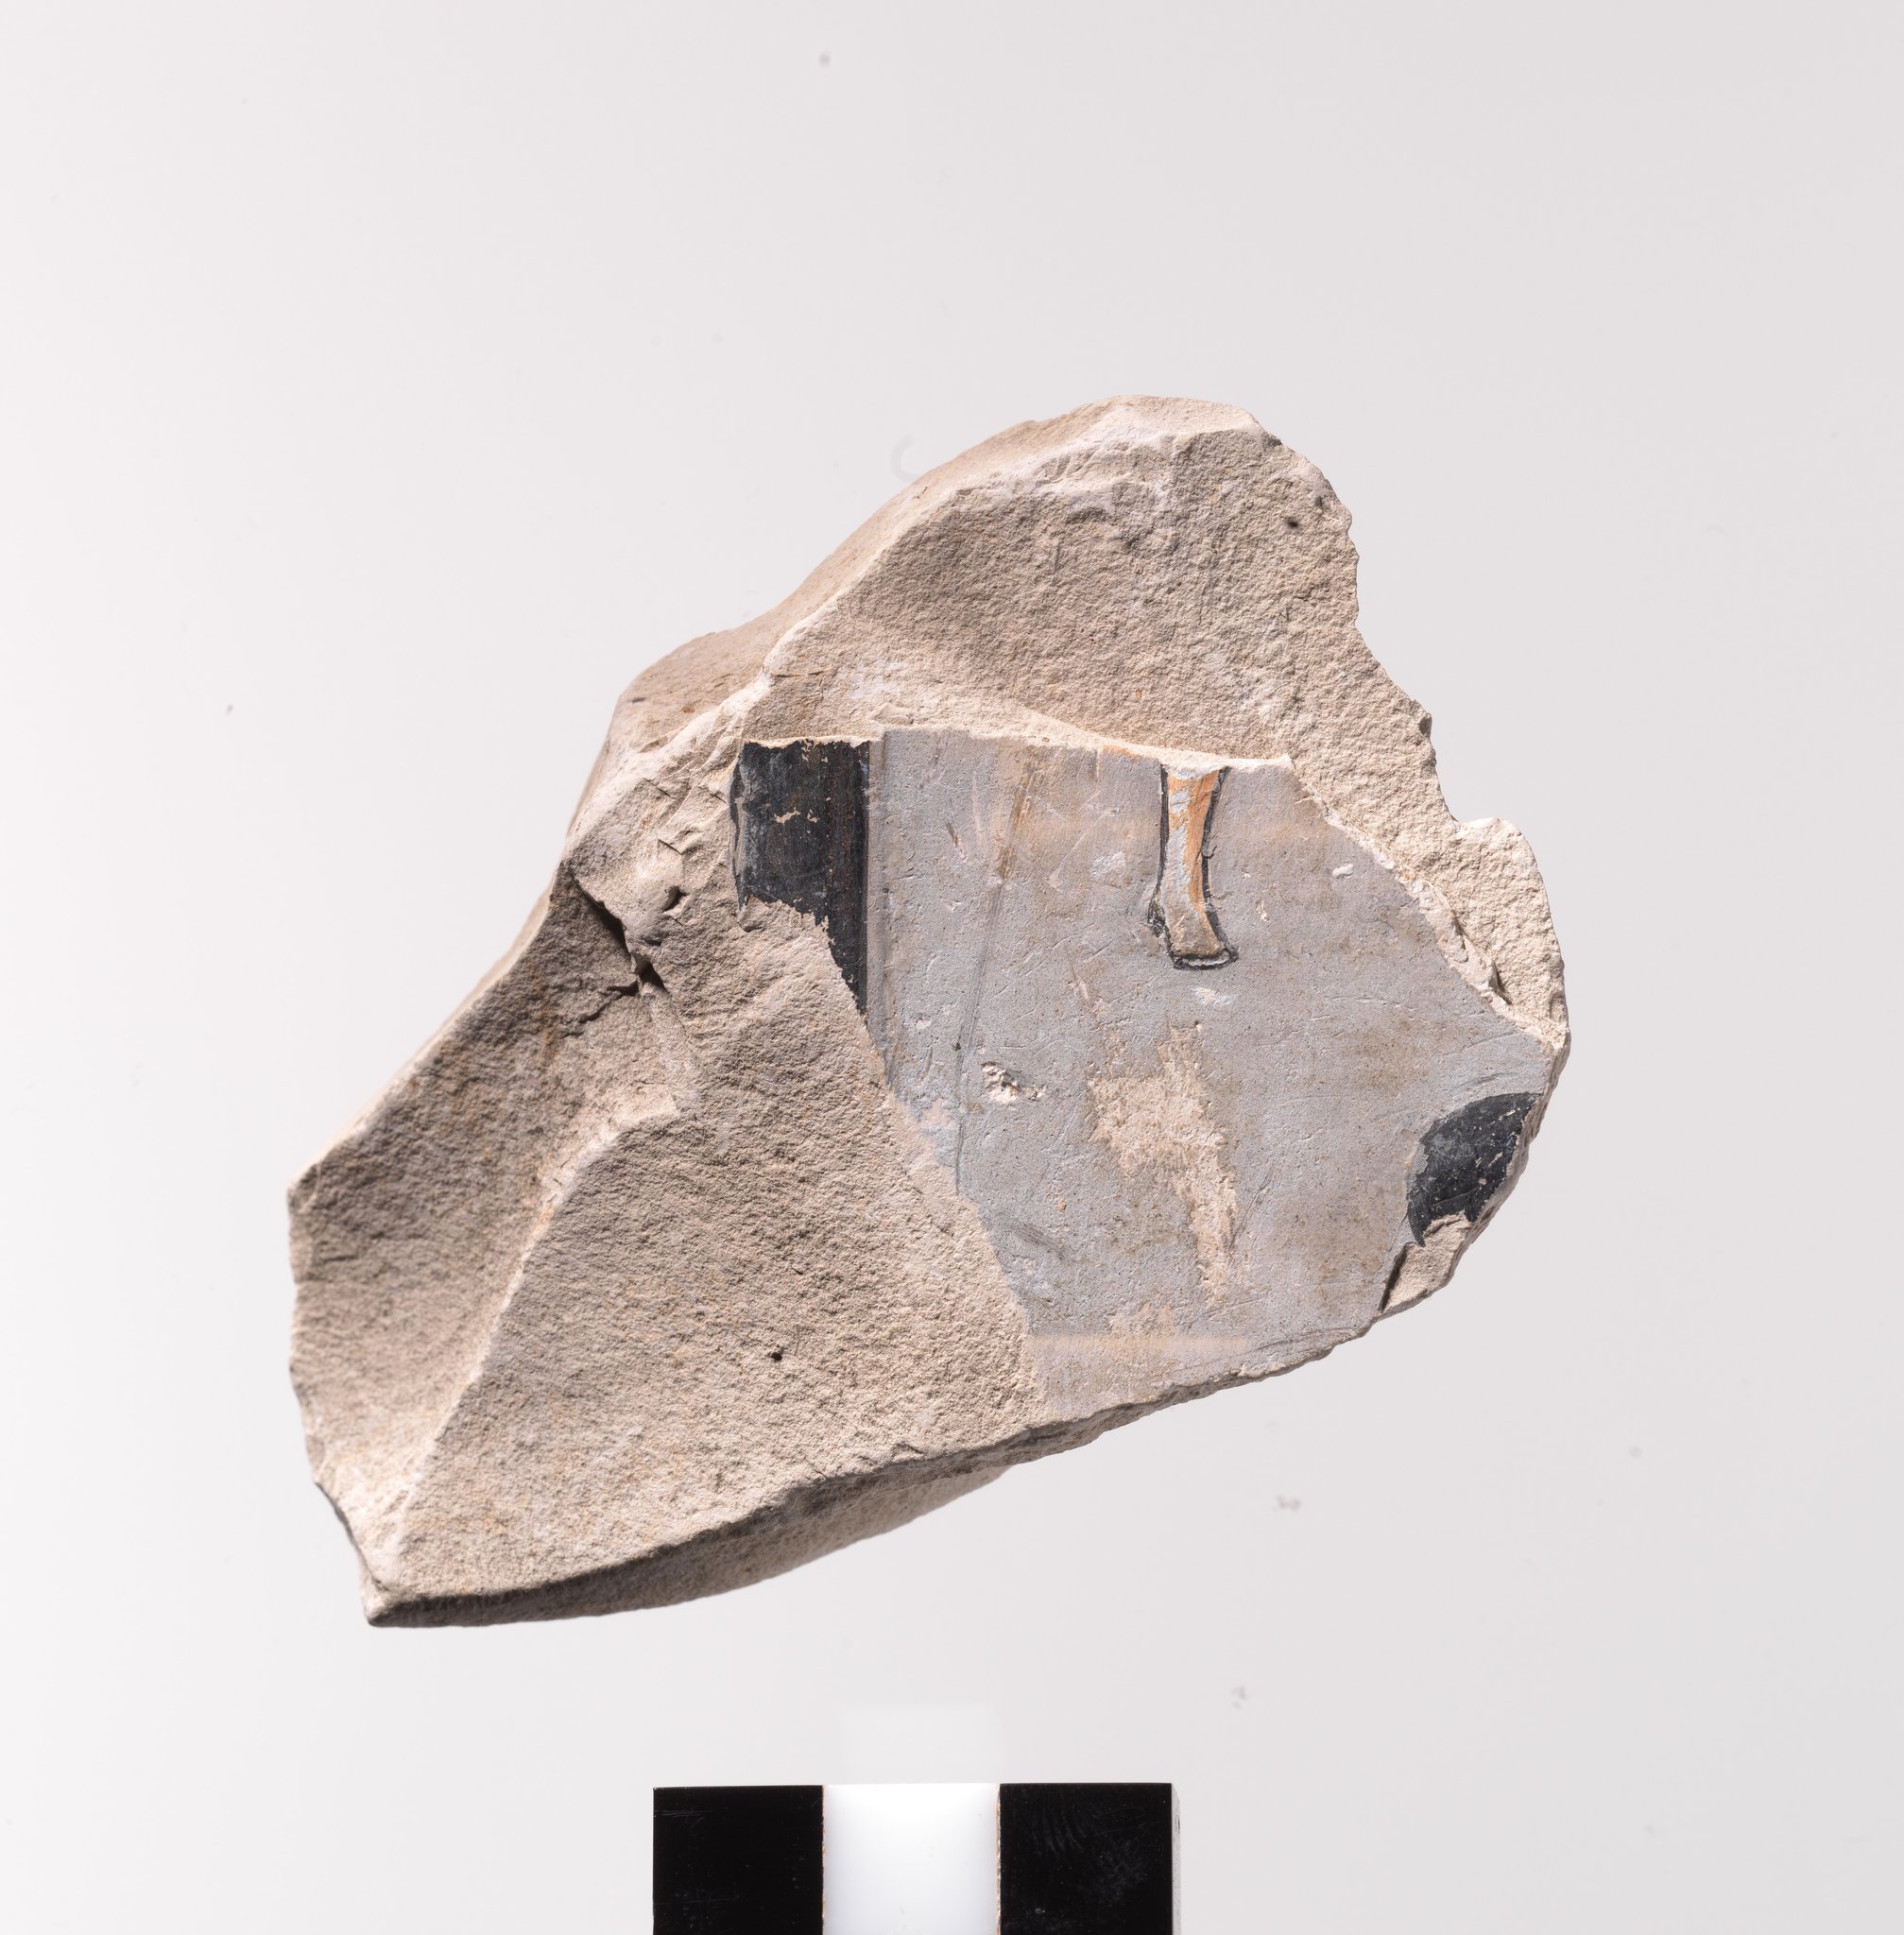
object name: relief fragment, tomb of meketre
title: Relief Fragment with Part of a Vertical Inscription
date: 1981-1975 BCE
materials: limestone, paint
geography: egypt